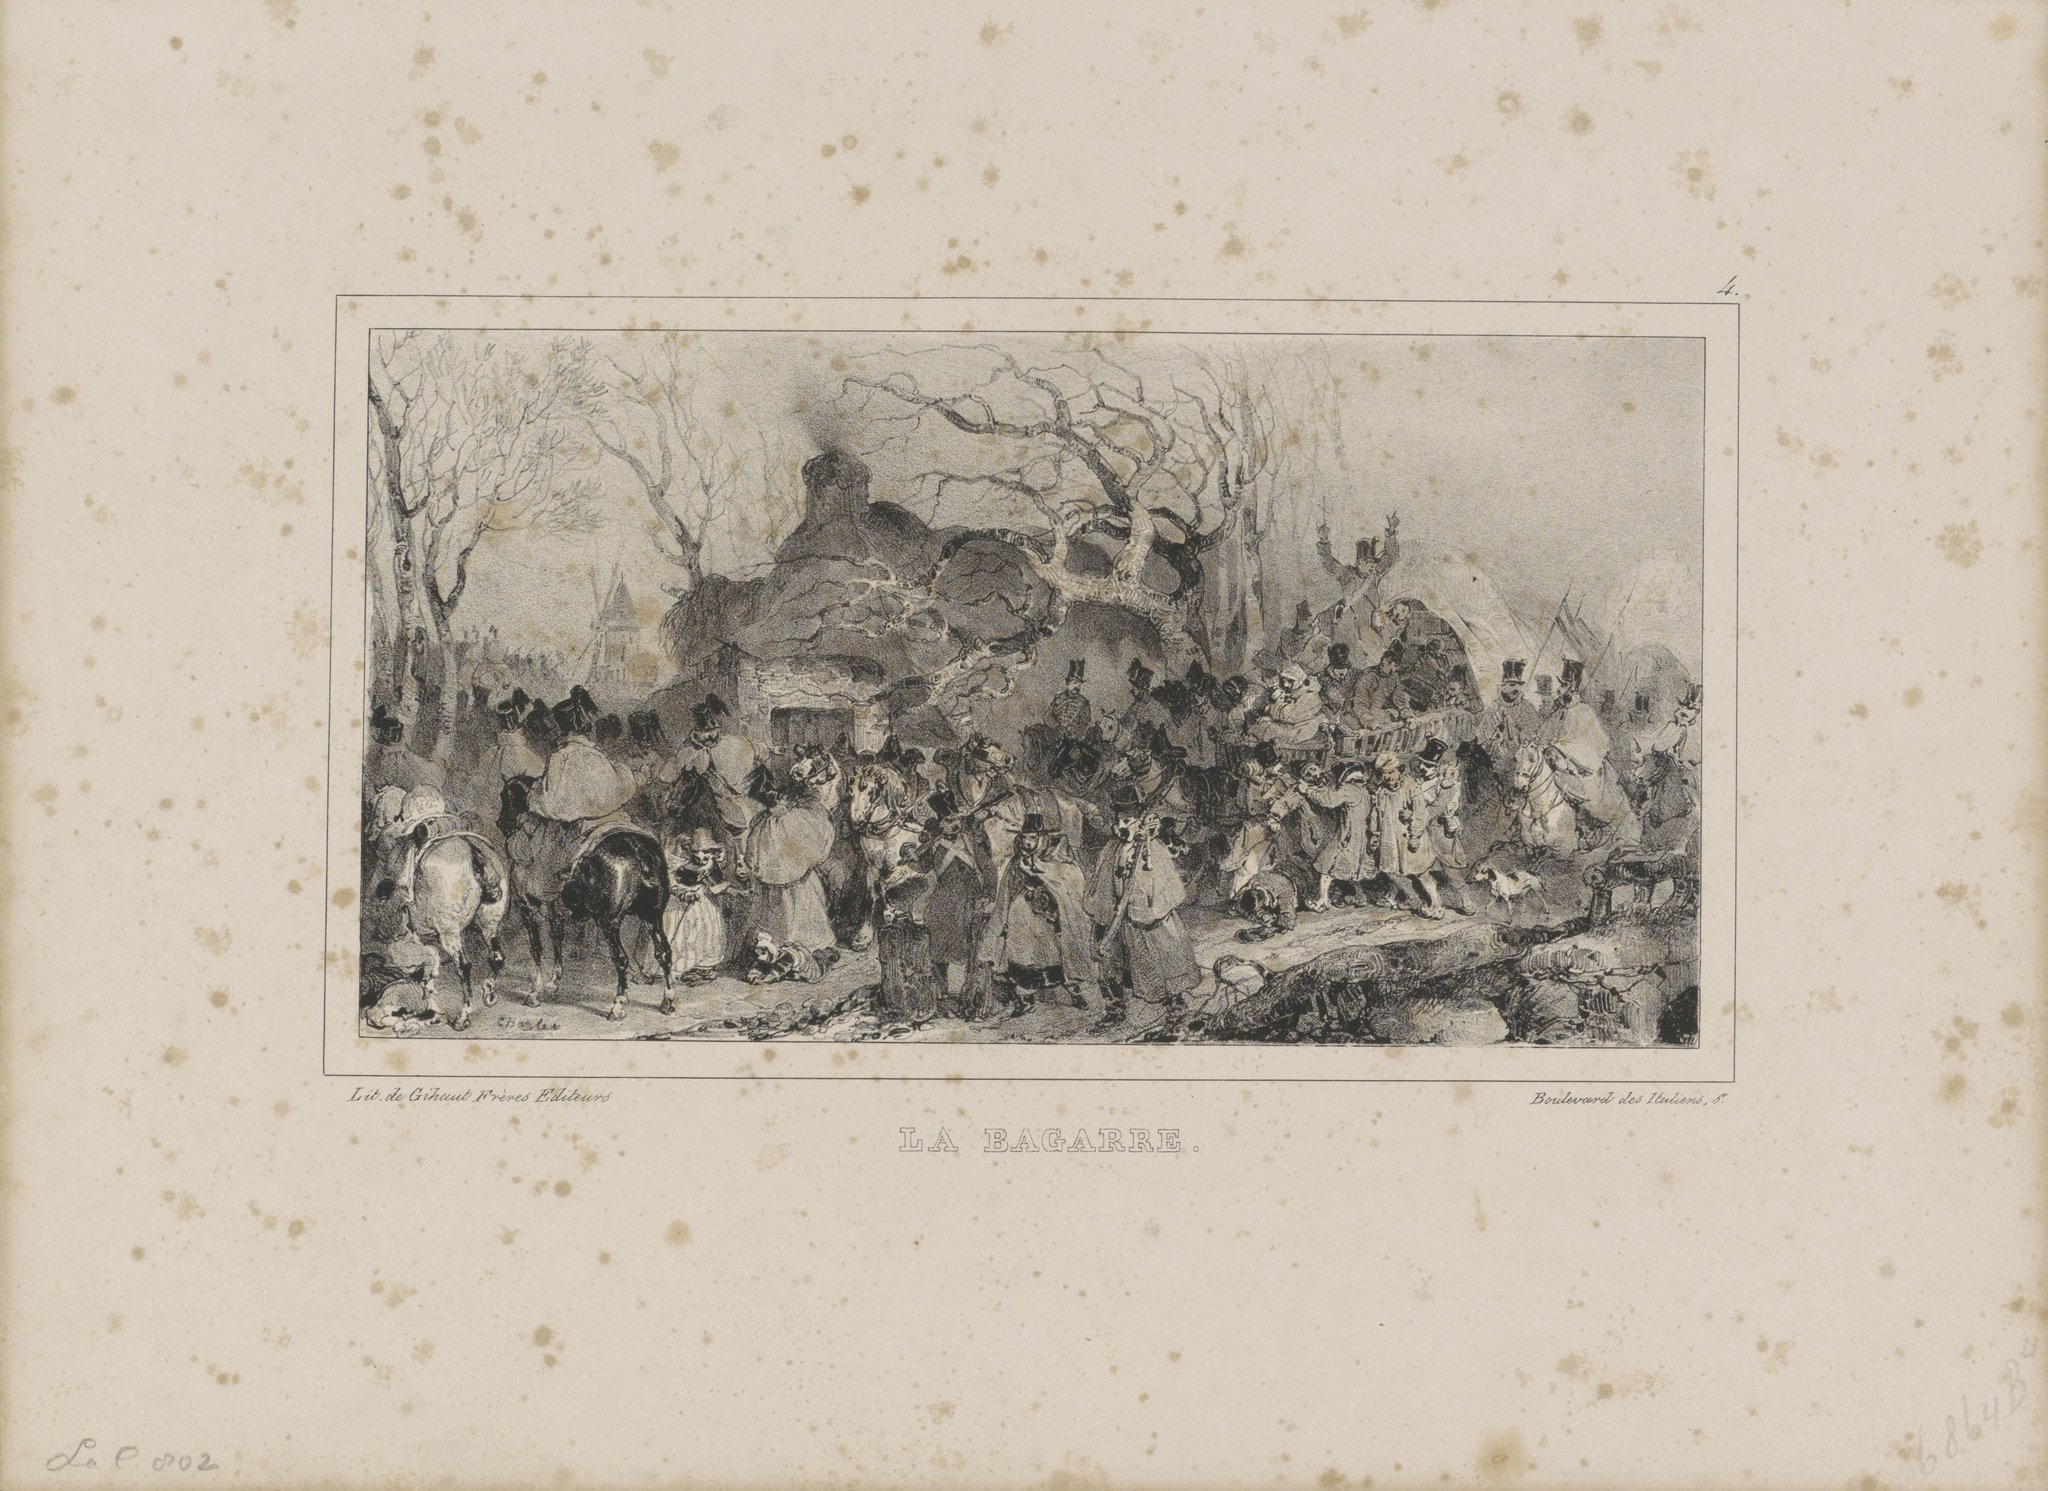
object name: print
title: Souvenirs de L'Armée du Nord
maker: nicolas toussaint charlet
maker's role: draughtsman, painter, print maker, printer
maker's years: 1792-1845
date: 1832-1833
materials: paper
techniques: lithograph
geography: paris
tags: troop movements, transportation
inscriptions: collector's mark: Lugt 2228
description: Opstootje onderweg tussen de berijders van een transportwagen en ruiters. Onderdeel van een serie van twintig bladen uit 1833 met voorstellingen van de militaire interventie van het Franse Noordelijke Leger in België in 1832.